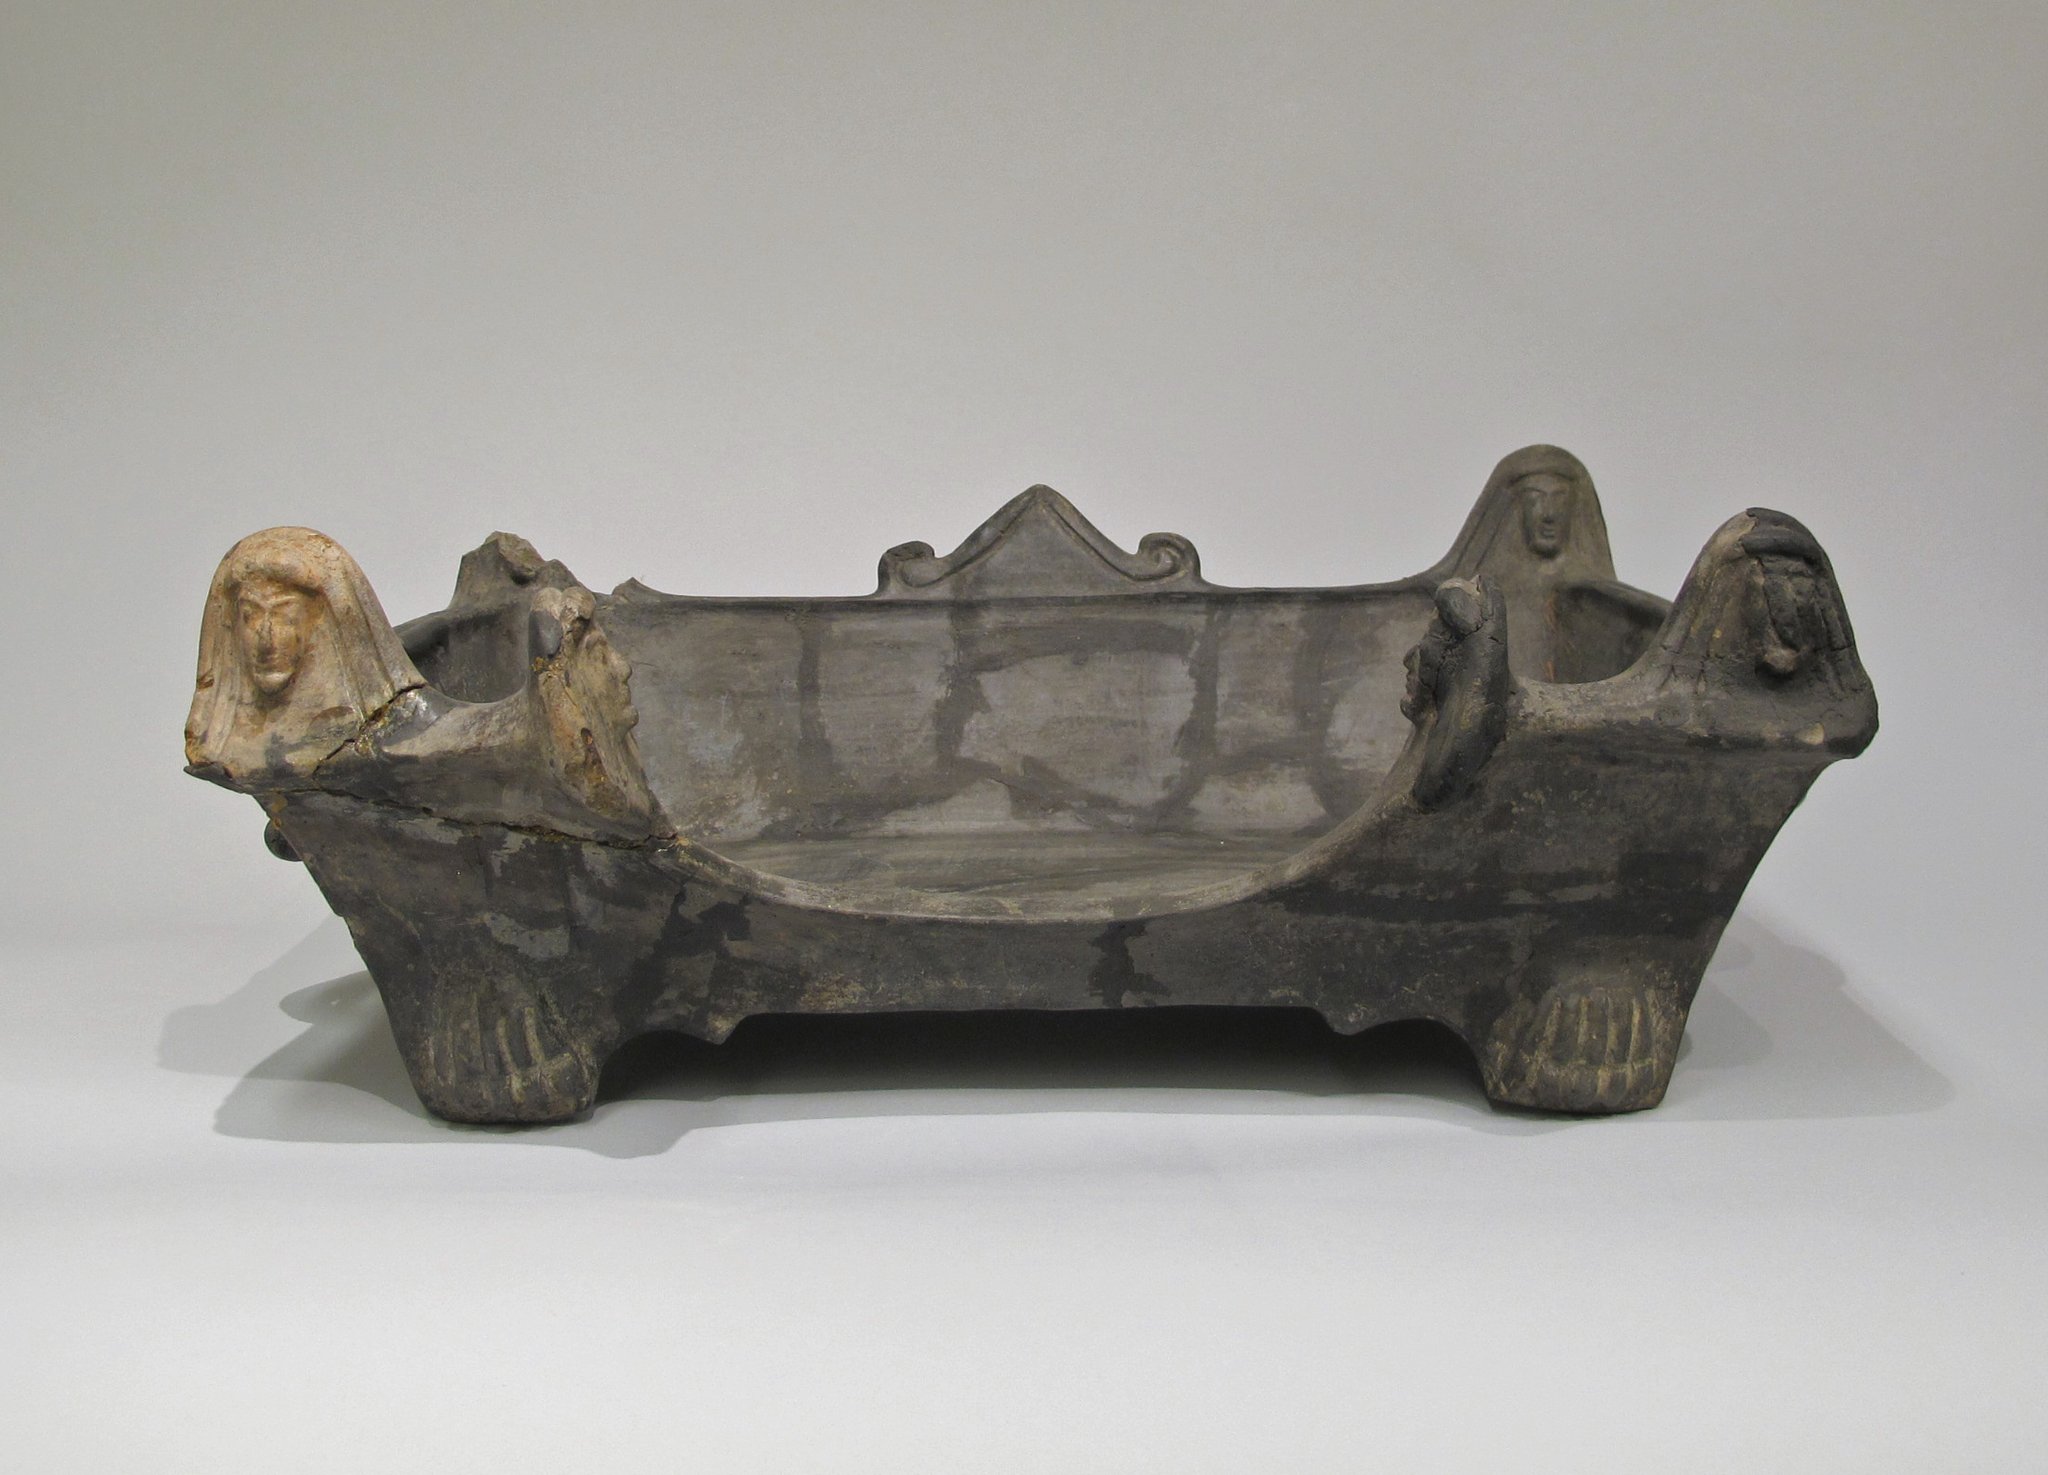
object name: focolare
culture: etruscan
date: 550-501 BCE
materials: terracotta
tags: heads